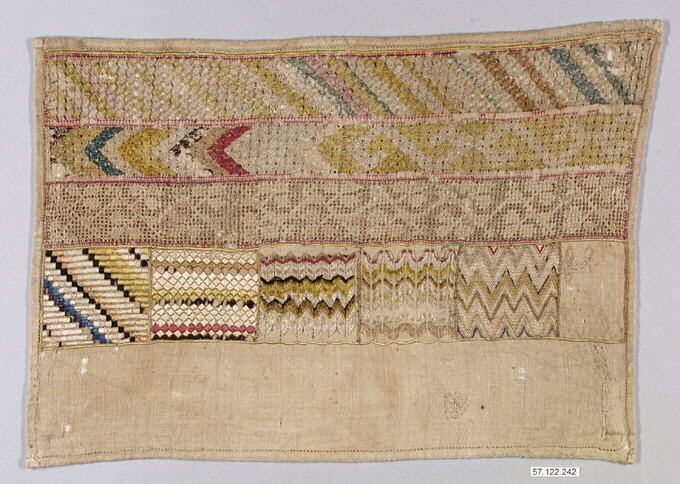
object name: sampler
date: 1701-1800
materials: linen, silk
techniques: embroidery